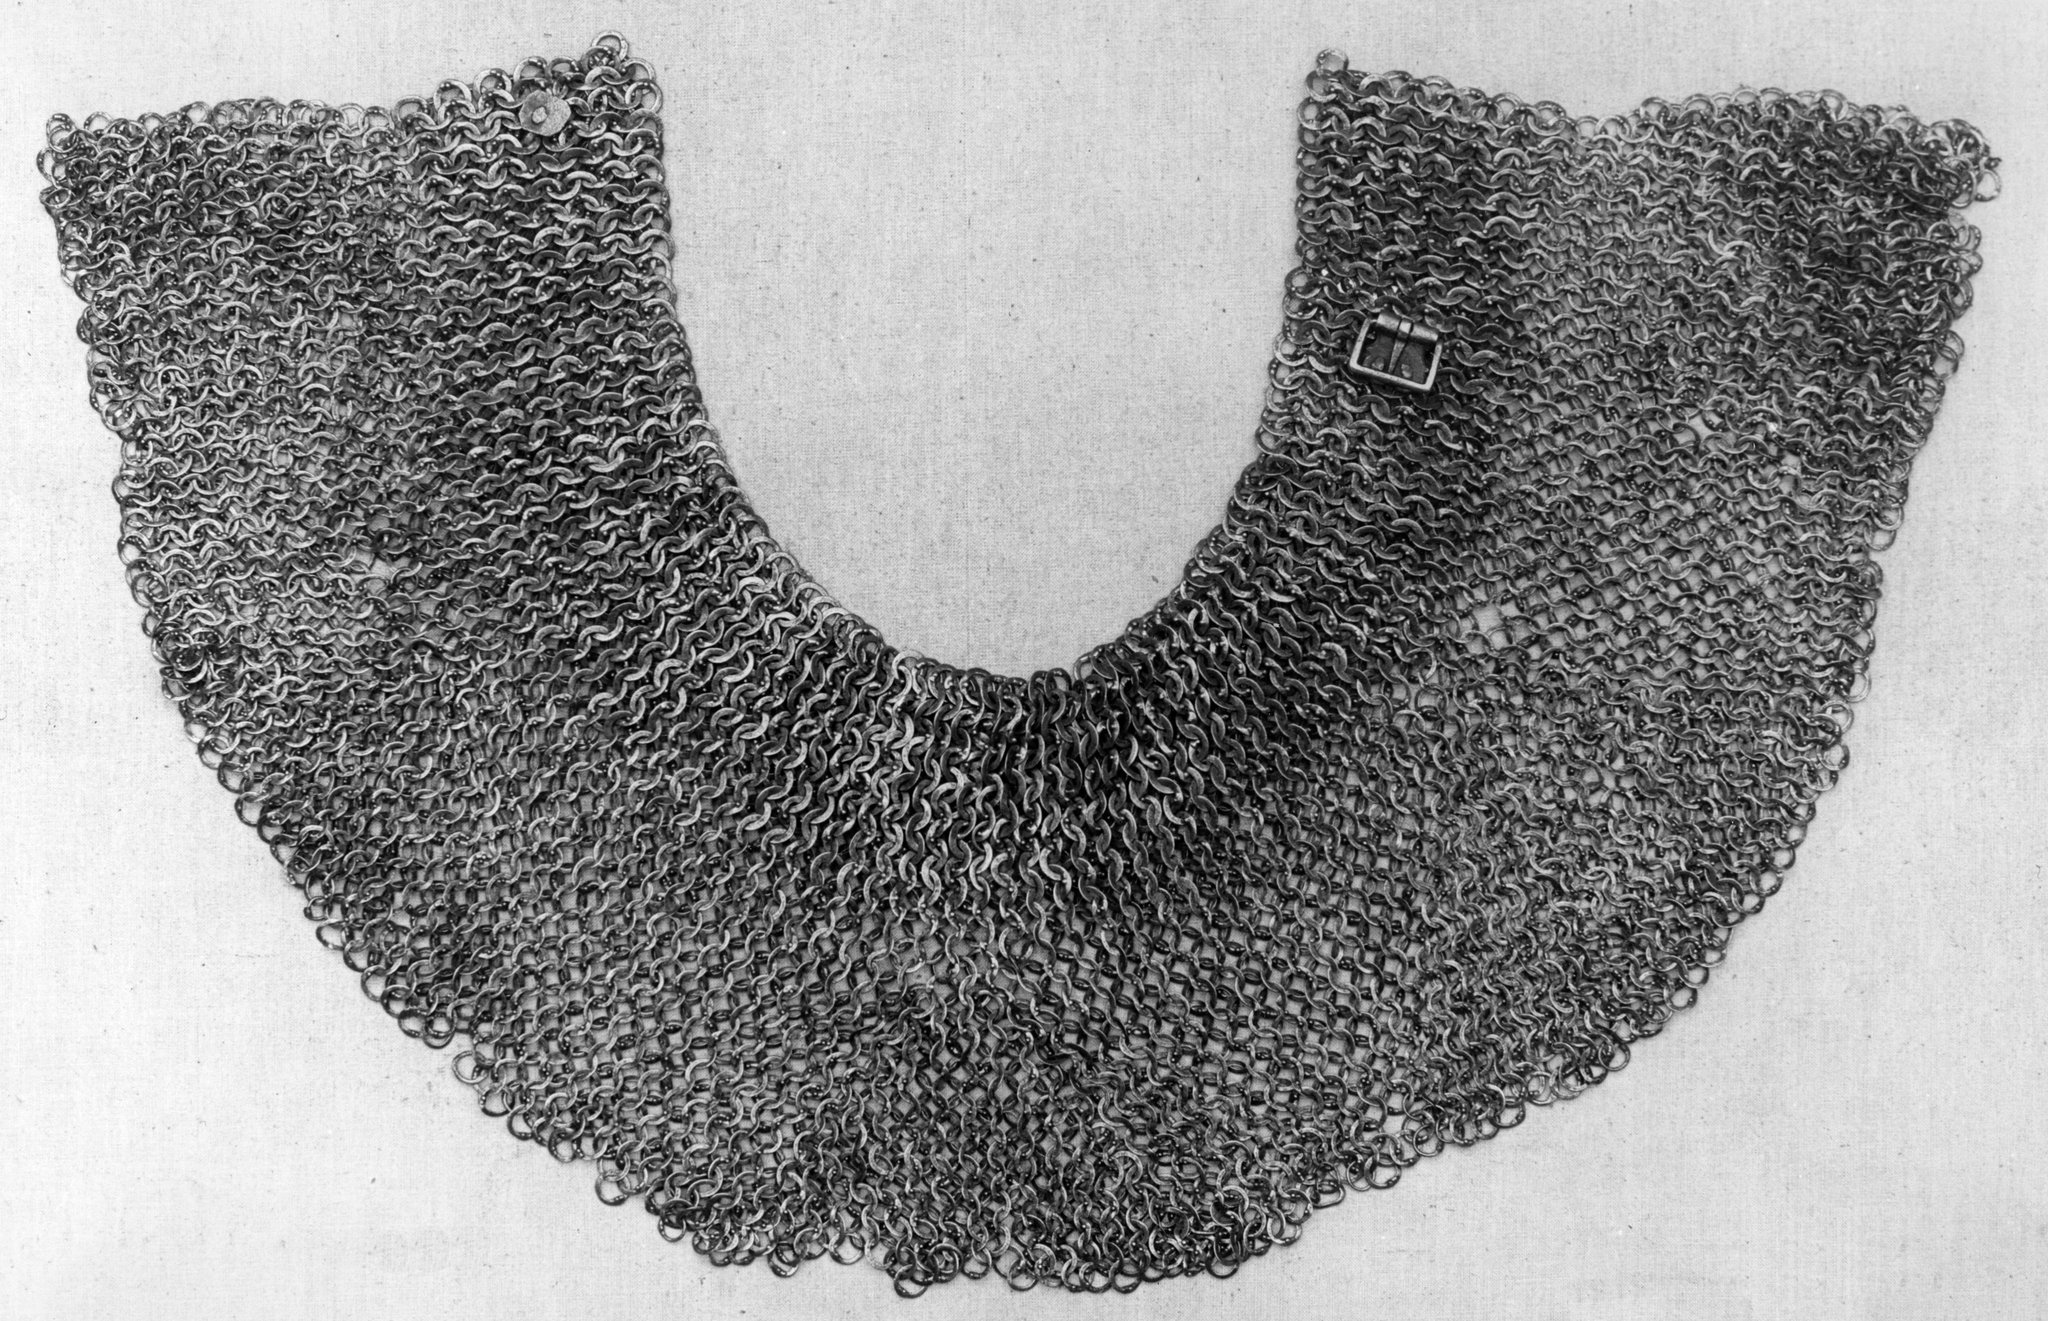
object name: collar of mail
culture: german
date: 1501-1600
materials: iron, steel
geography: germany